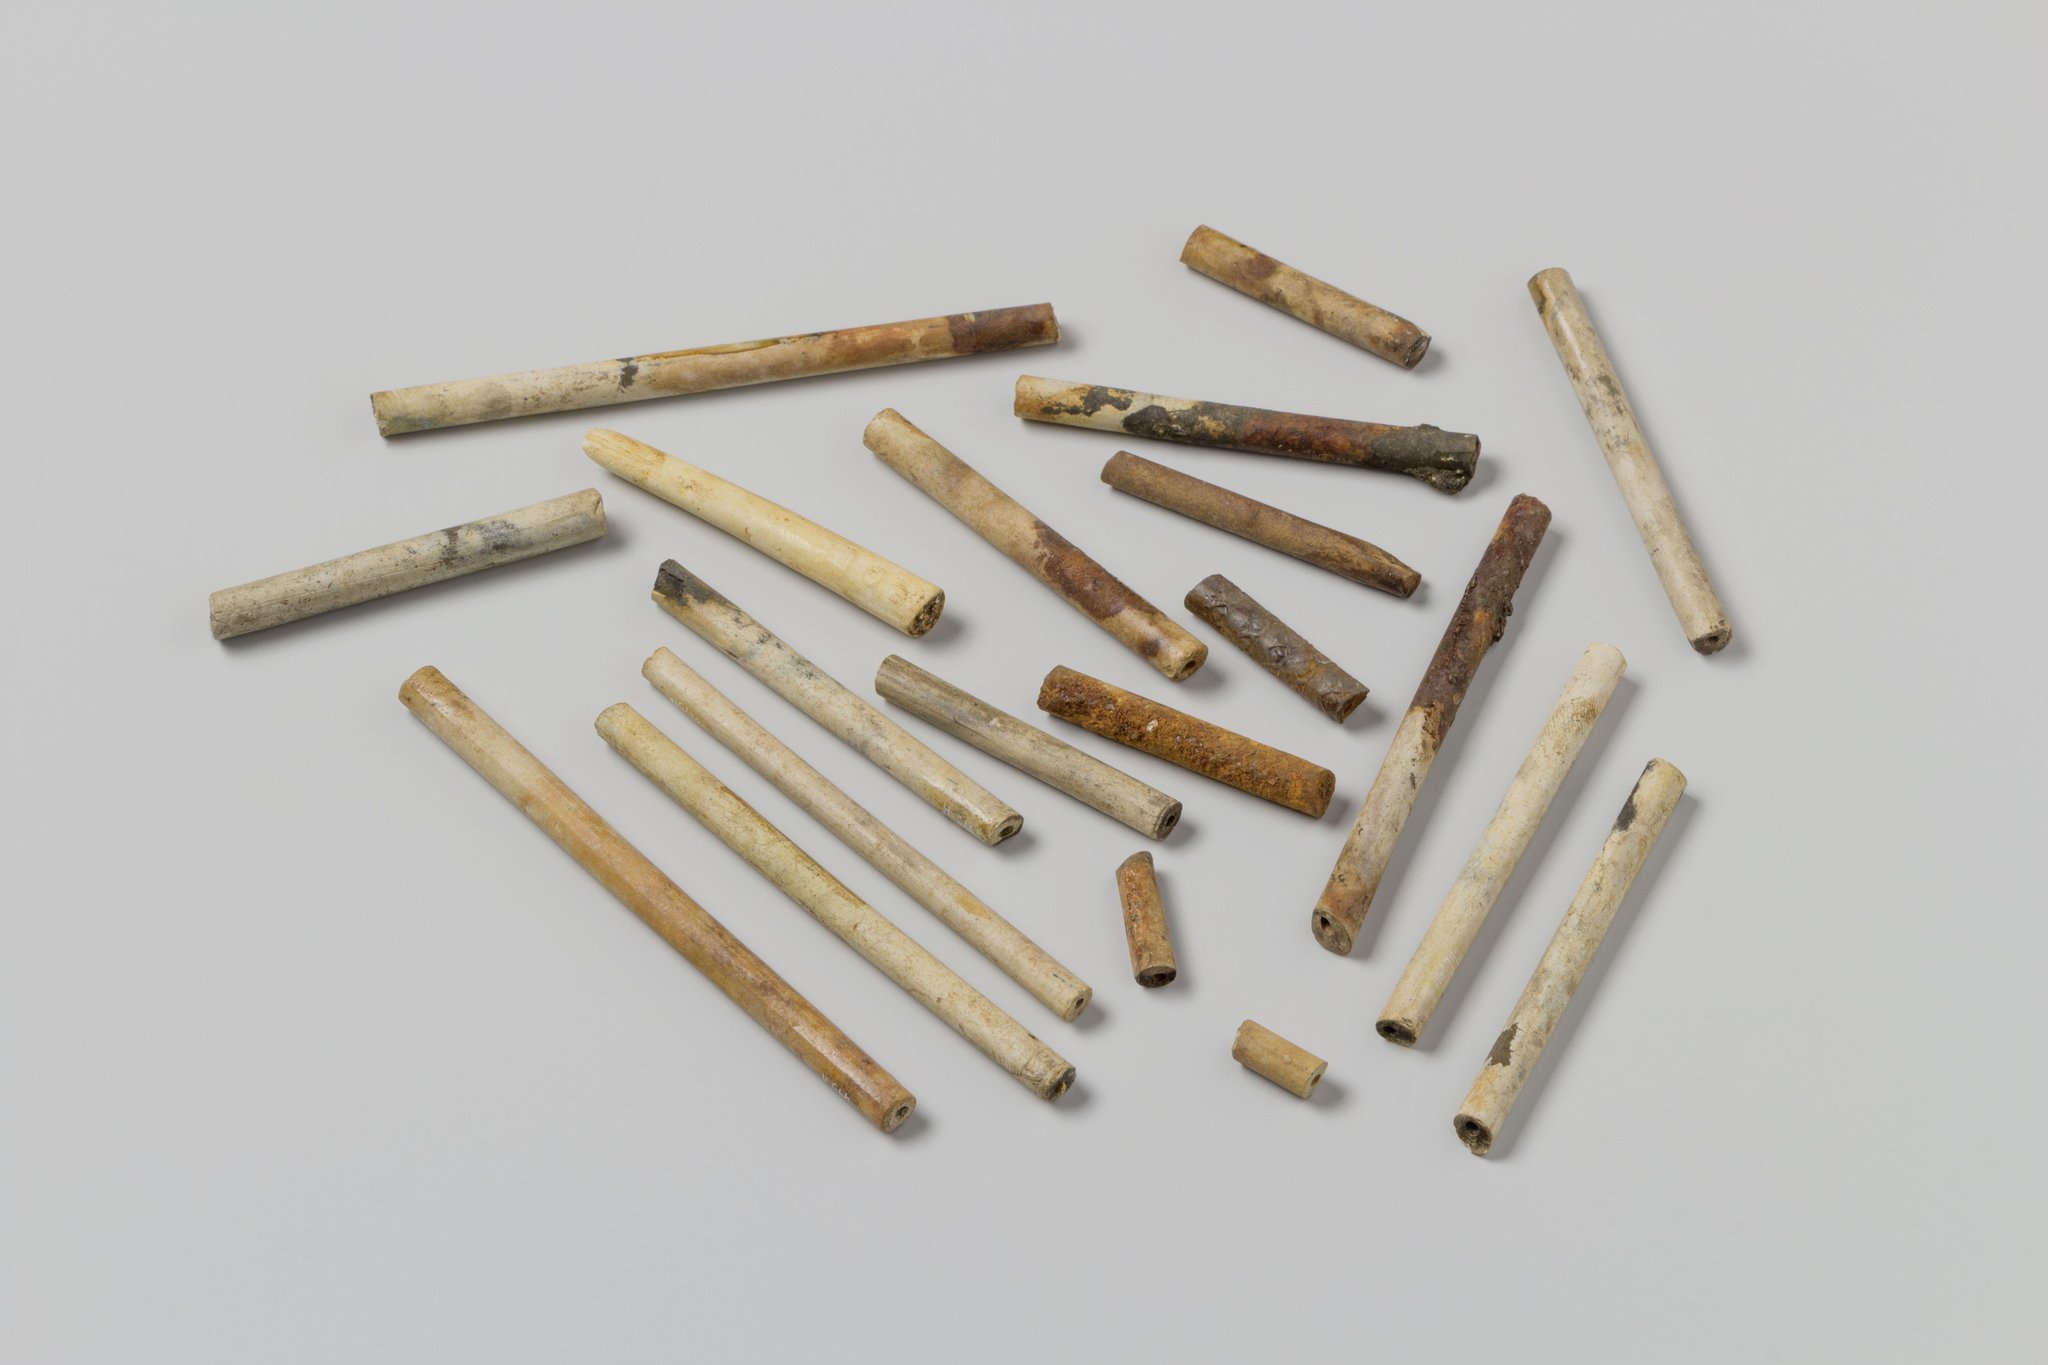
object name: pipe stem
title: Fragmenten pijpenstelen uit het wrak van de Oost-Indiëvaarder Hollandia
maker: Anonymous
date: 1700-1743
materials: clay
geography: netherlands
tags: verenigde oostindische compagnie, hollandia (schip), annet